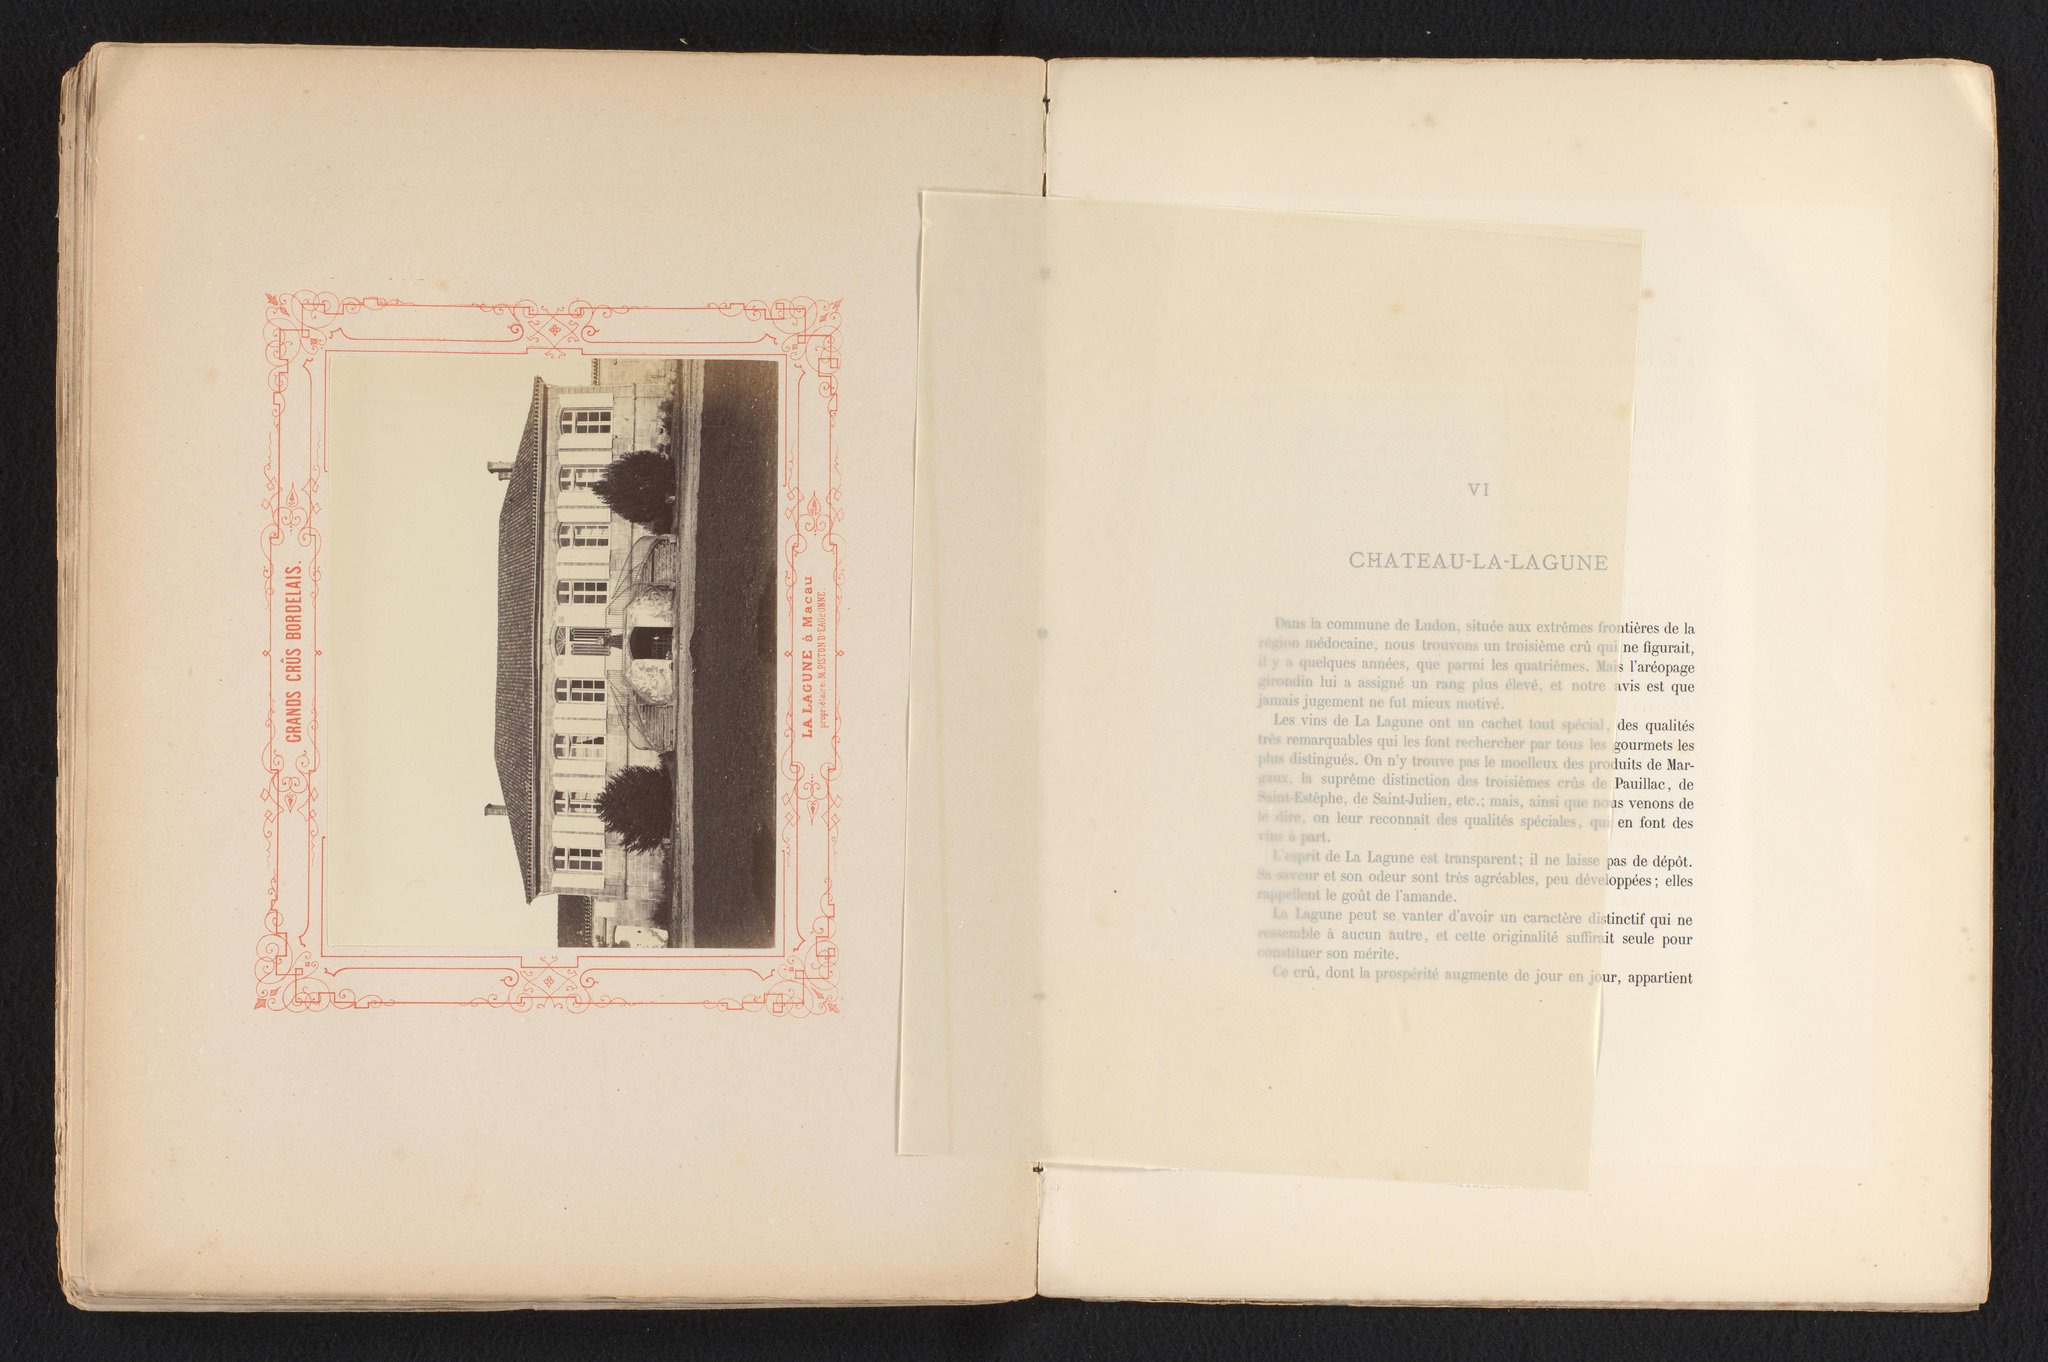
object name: page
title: Grands crûs Bordelais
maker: alfred danflou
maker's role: fotograaf, schrijver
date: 1862-1867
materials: paper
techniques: albumen print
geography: macau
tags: castle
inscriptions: inscription: ‘propriétaire: M. PISTON D'EAUBONNE.’